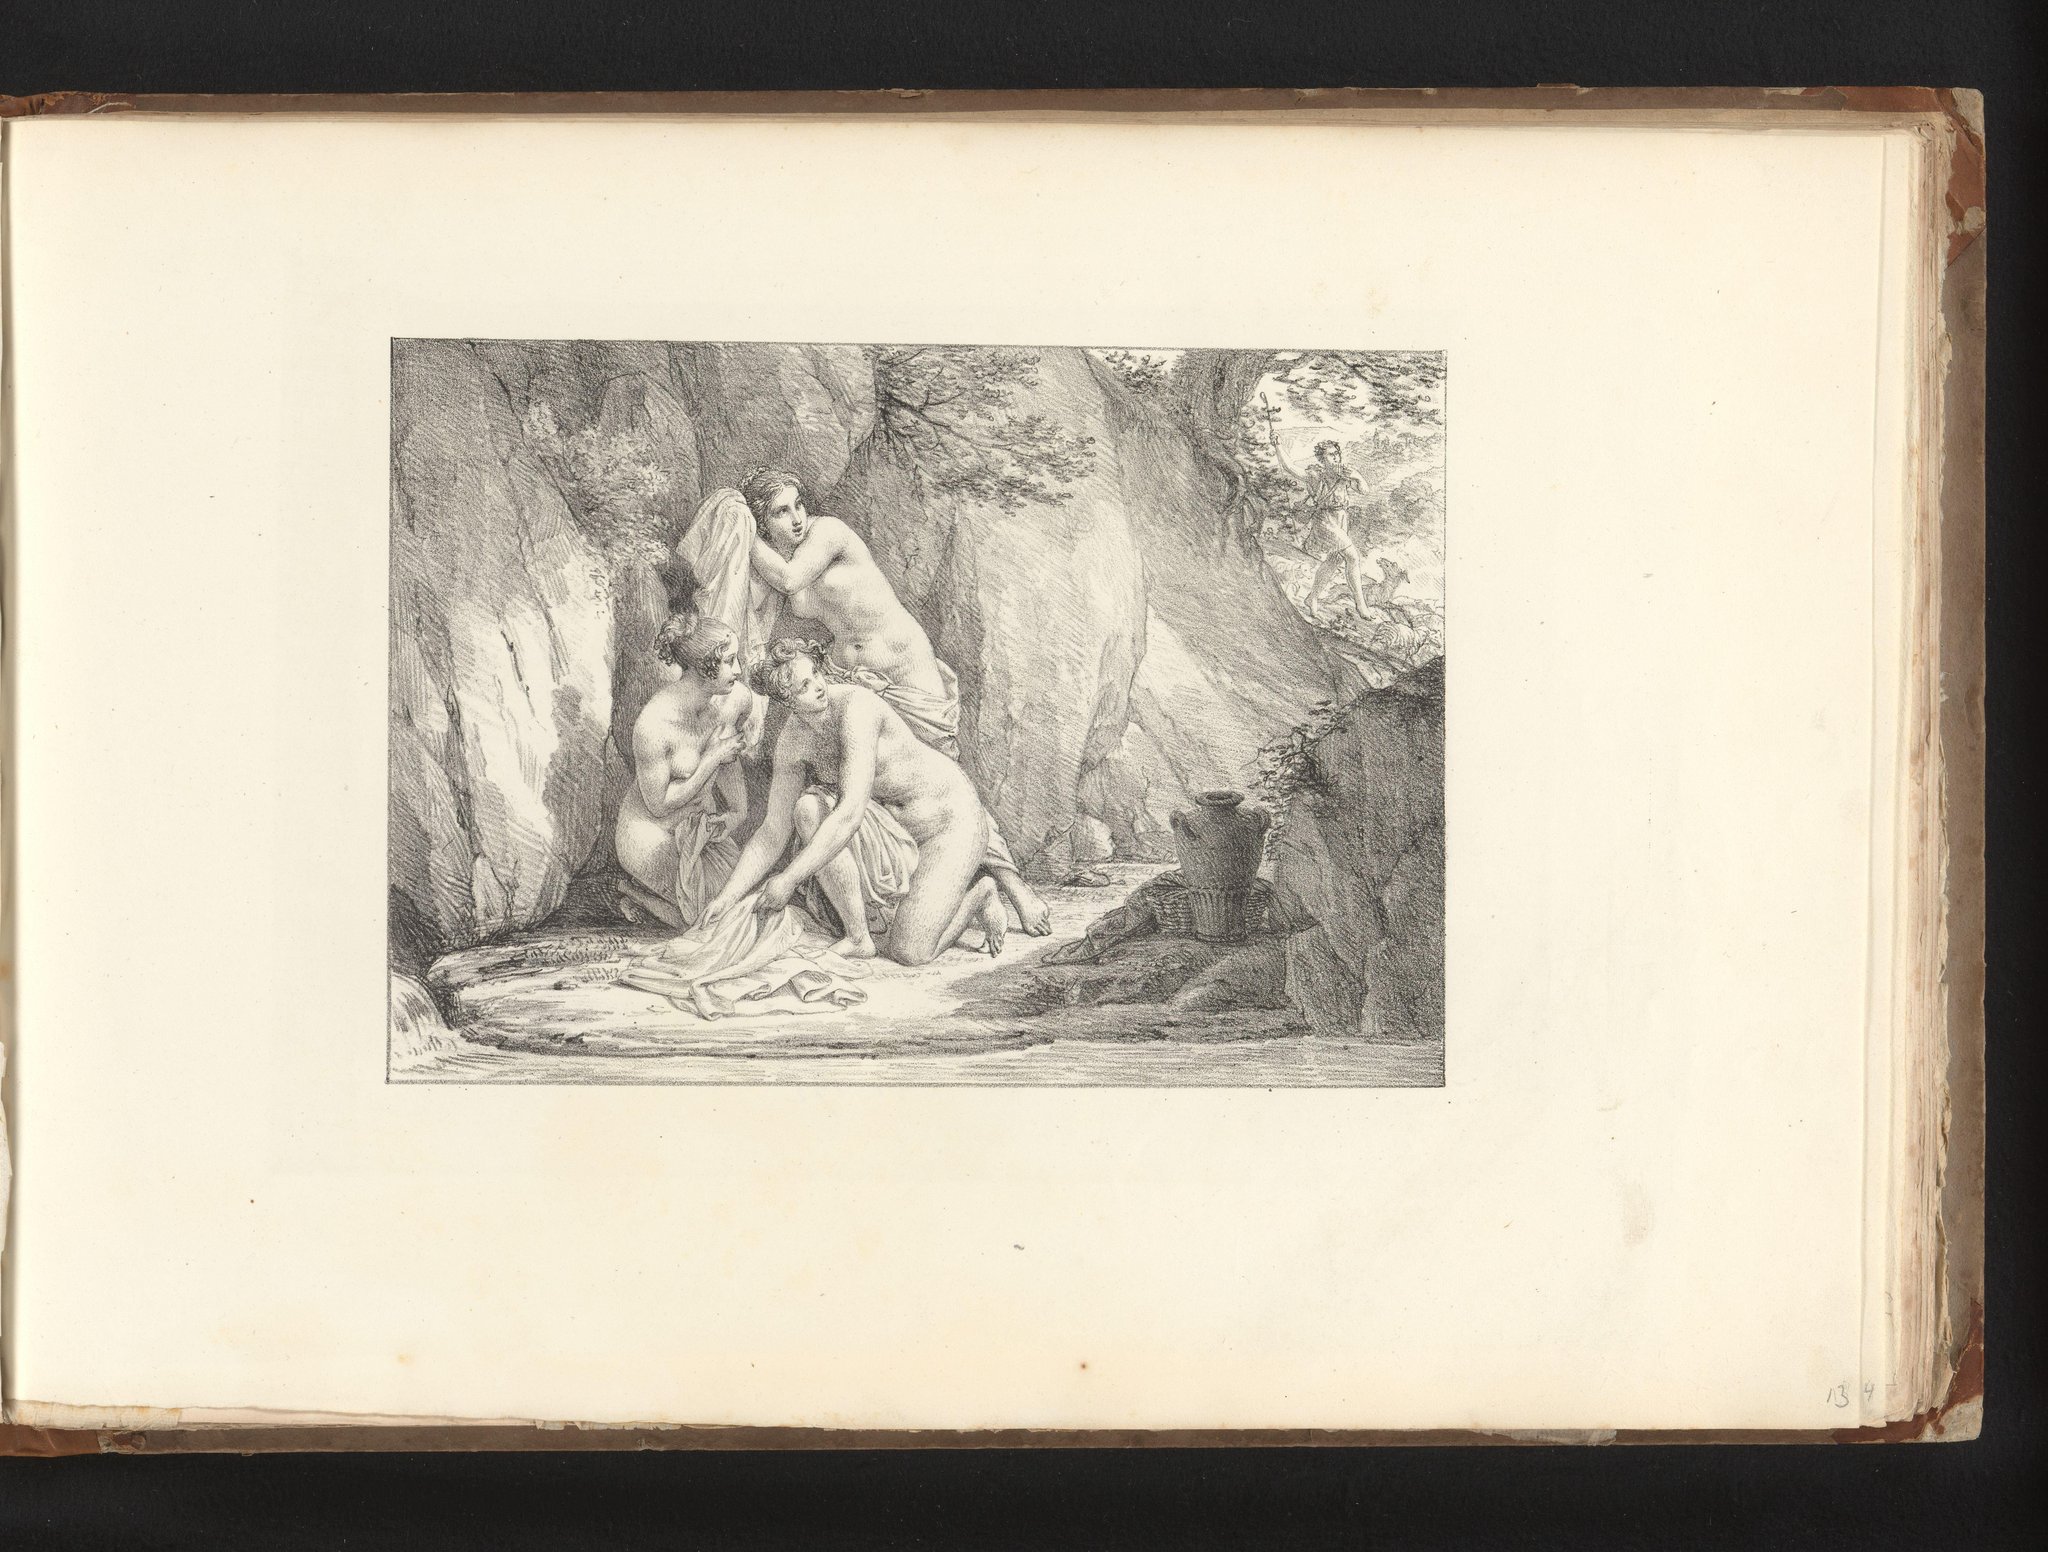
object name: print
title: Diana en Actaeon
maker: Anonymous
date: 1818-1819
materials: paper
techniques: lithograph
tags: actaeon changed into a stag: as punishment for seeing her bathe, diana changes actaeon, the hunter, into a stag (ovid, metamorphoses iii 193), diana bathing with her nymphs